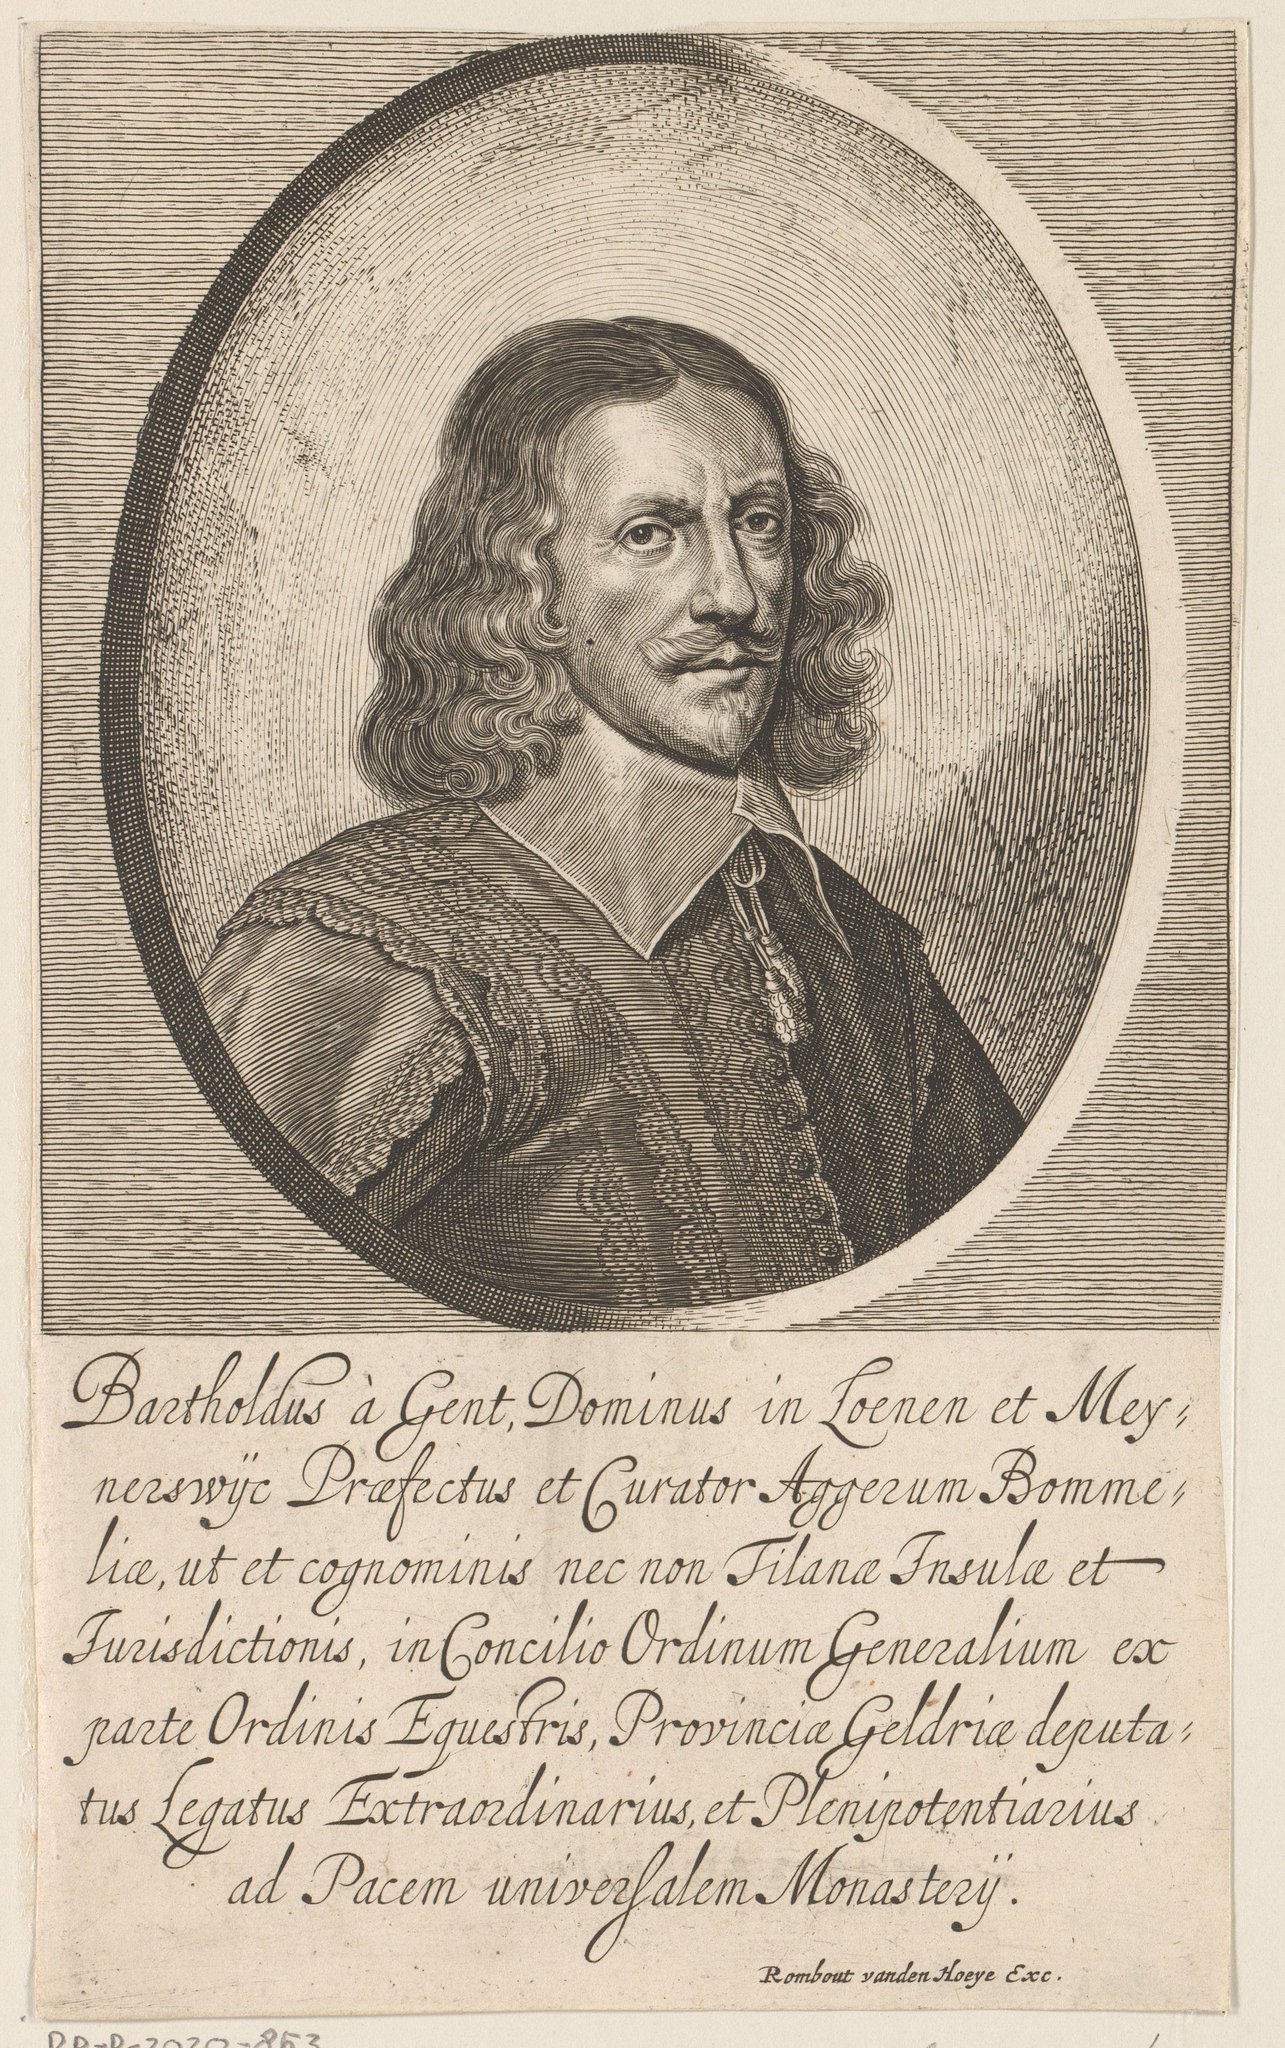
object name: print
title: Portret van Barthold van Gent, heer van Meynerswijck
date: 1644-1671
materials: paper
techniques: engraving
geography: amsterdam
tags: official; civil servant; functionary (in general), historical persons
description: Prent maakt deel uit van een serie van 43 prenten. Eerdere staat van prent gebruikt in de serie 'Icones legatorum Monasterii et Osnabrugae existentium', uitgegeven door Abraham van Waesbergen in Amsterdam.